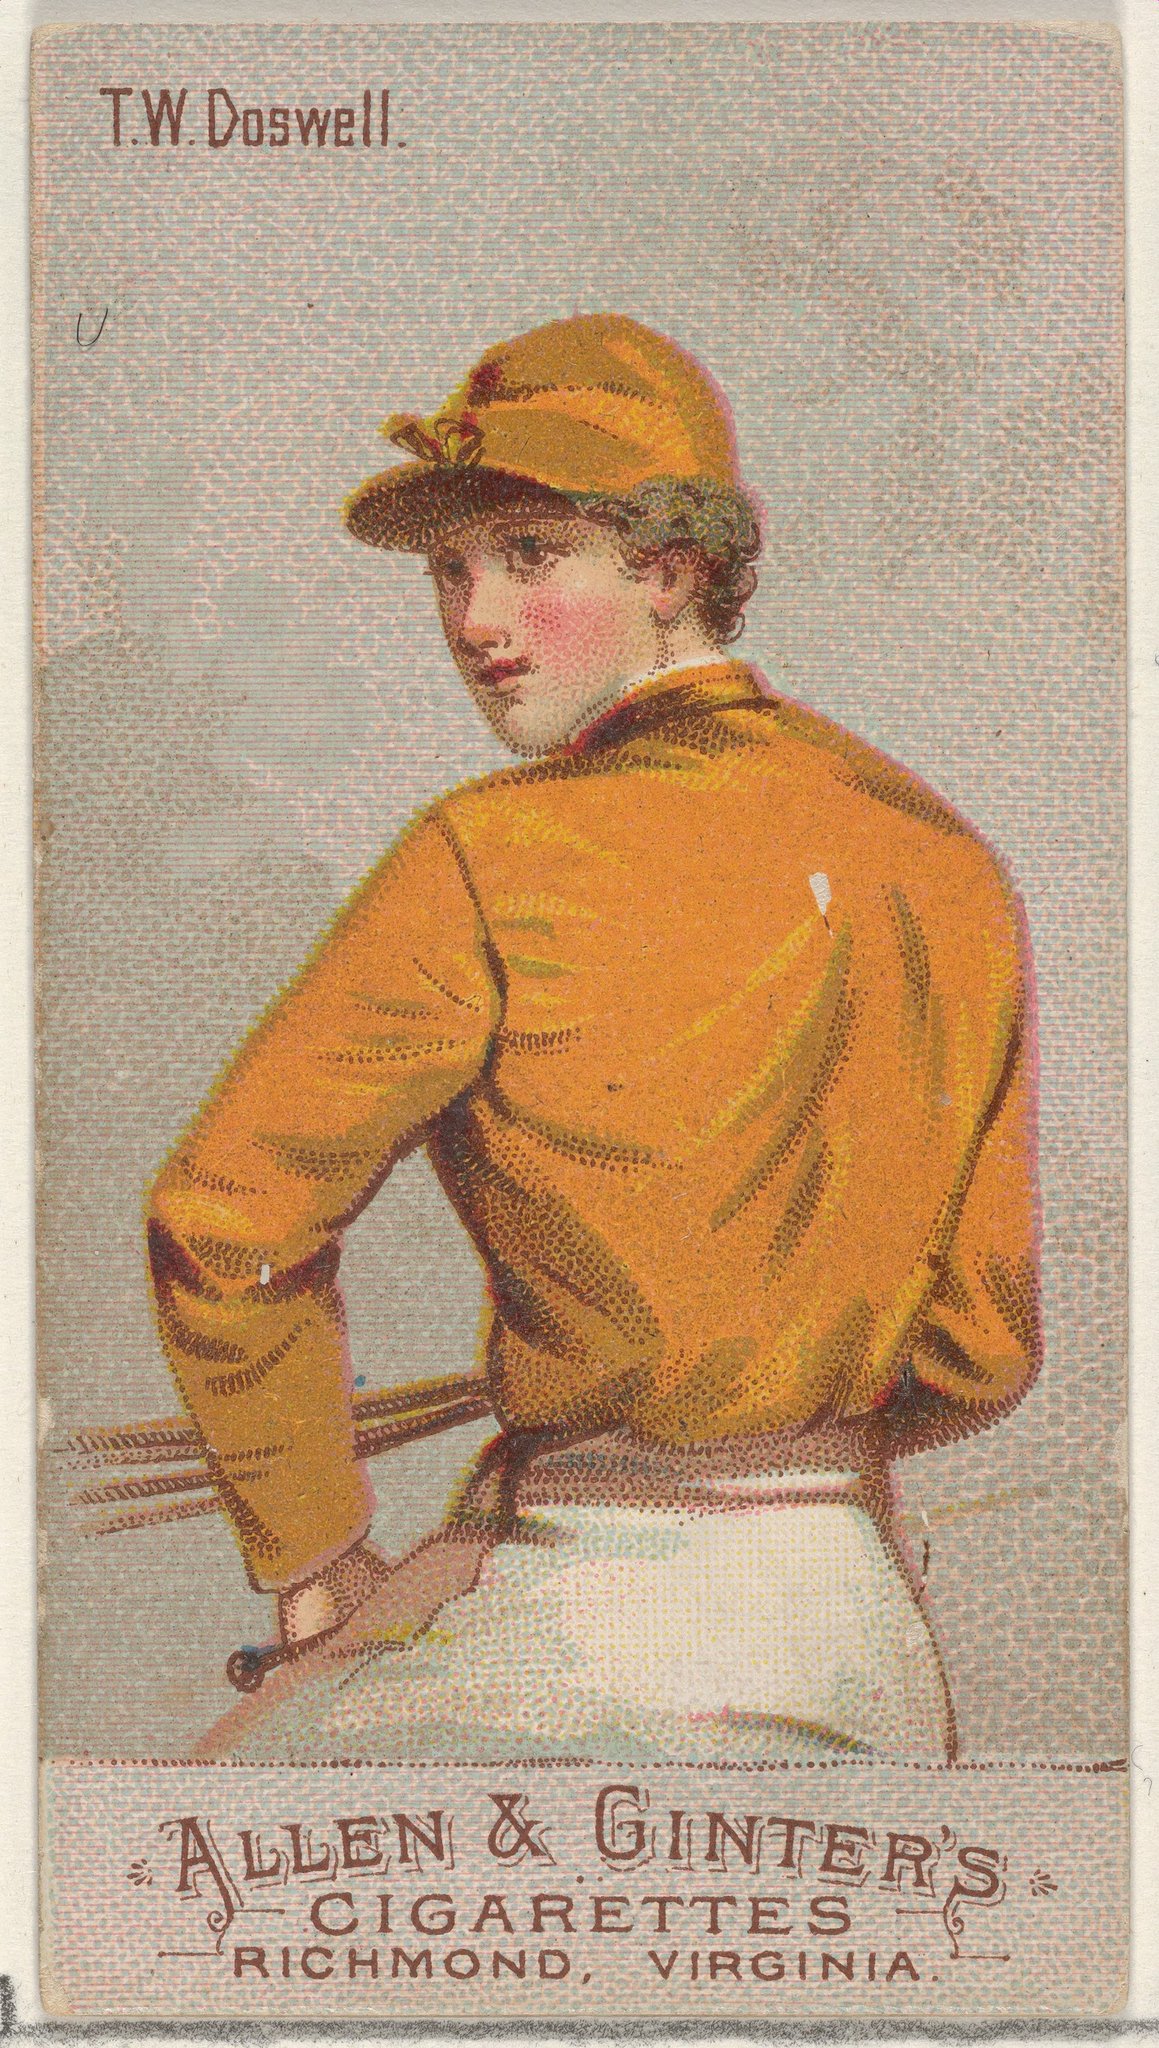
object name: print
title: T.W. Doswell, from the Racing Colors of the World series (N22b) for Allen & Ginter Cigarettes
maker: allen & ginter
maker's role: publisher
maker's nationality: american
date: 1888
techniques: color lithograph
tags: women,athletes,jockeys